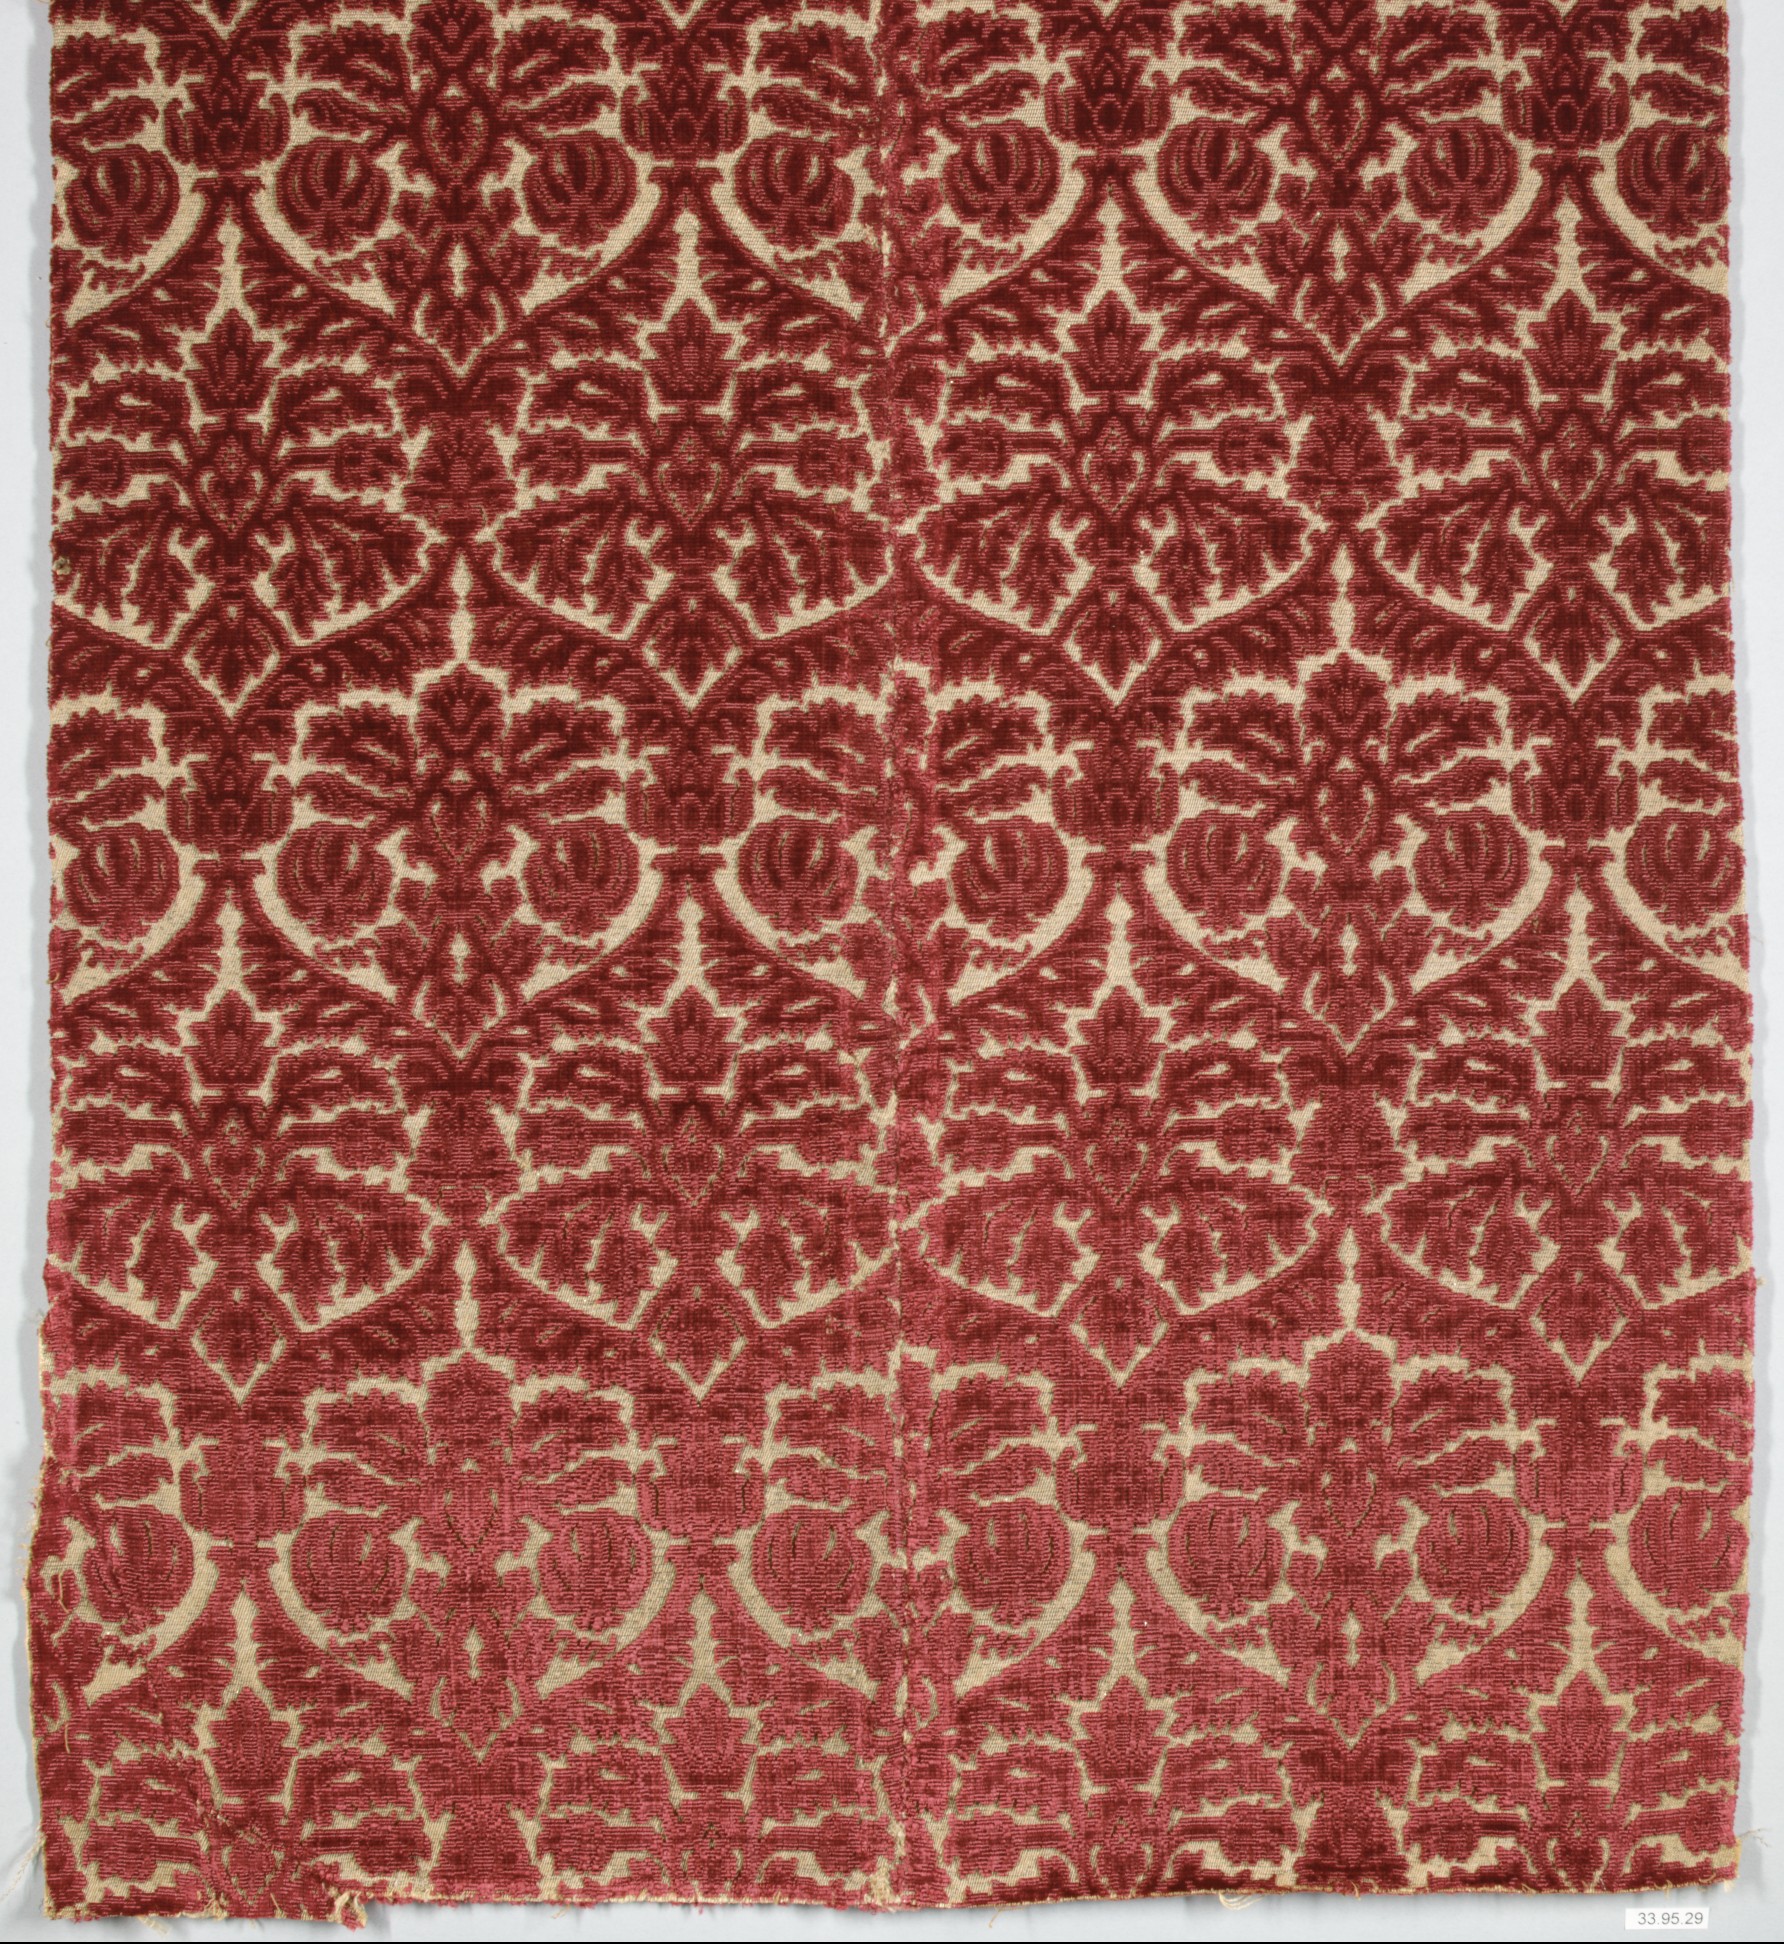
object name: piece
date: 1551-1600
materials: metal thread, silk